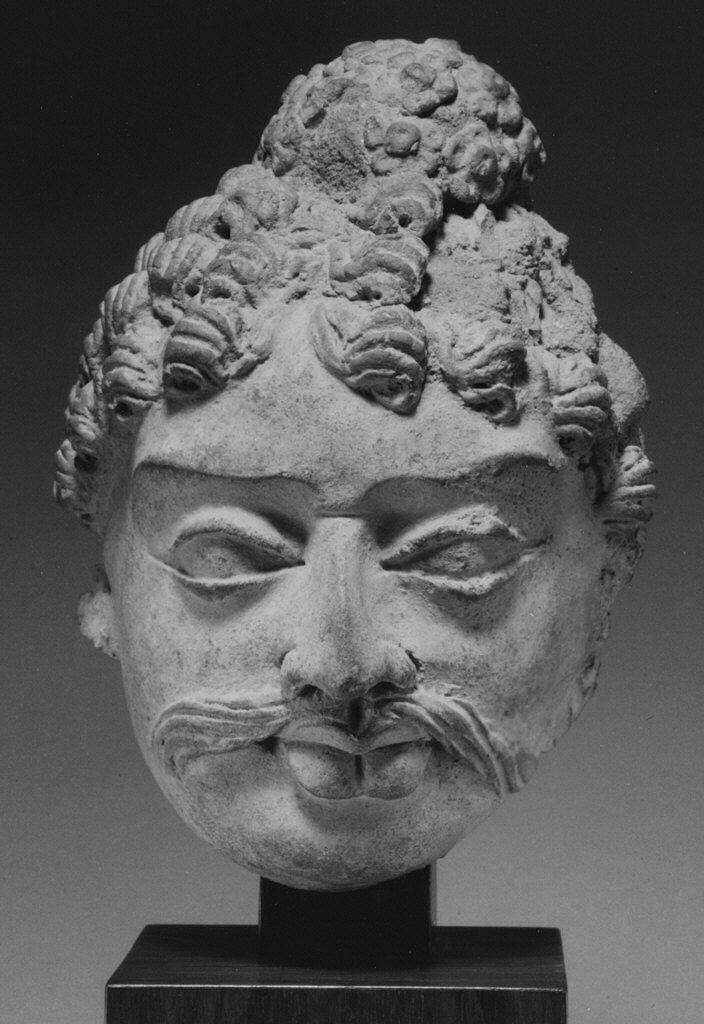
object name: head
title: Head of a Male Figure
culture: india, jammu and kashmir, akhnur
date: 501-700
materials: clay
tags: kashmir,heads,men